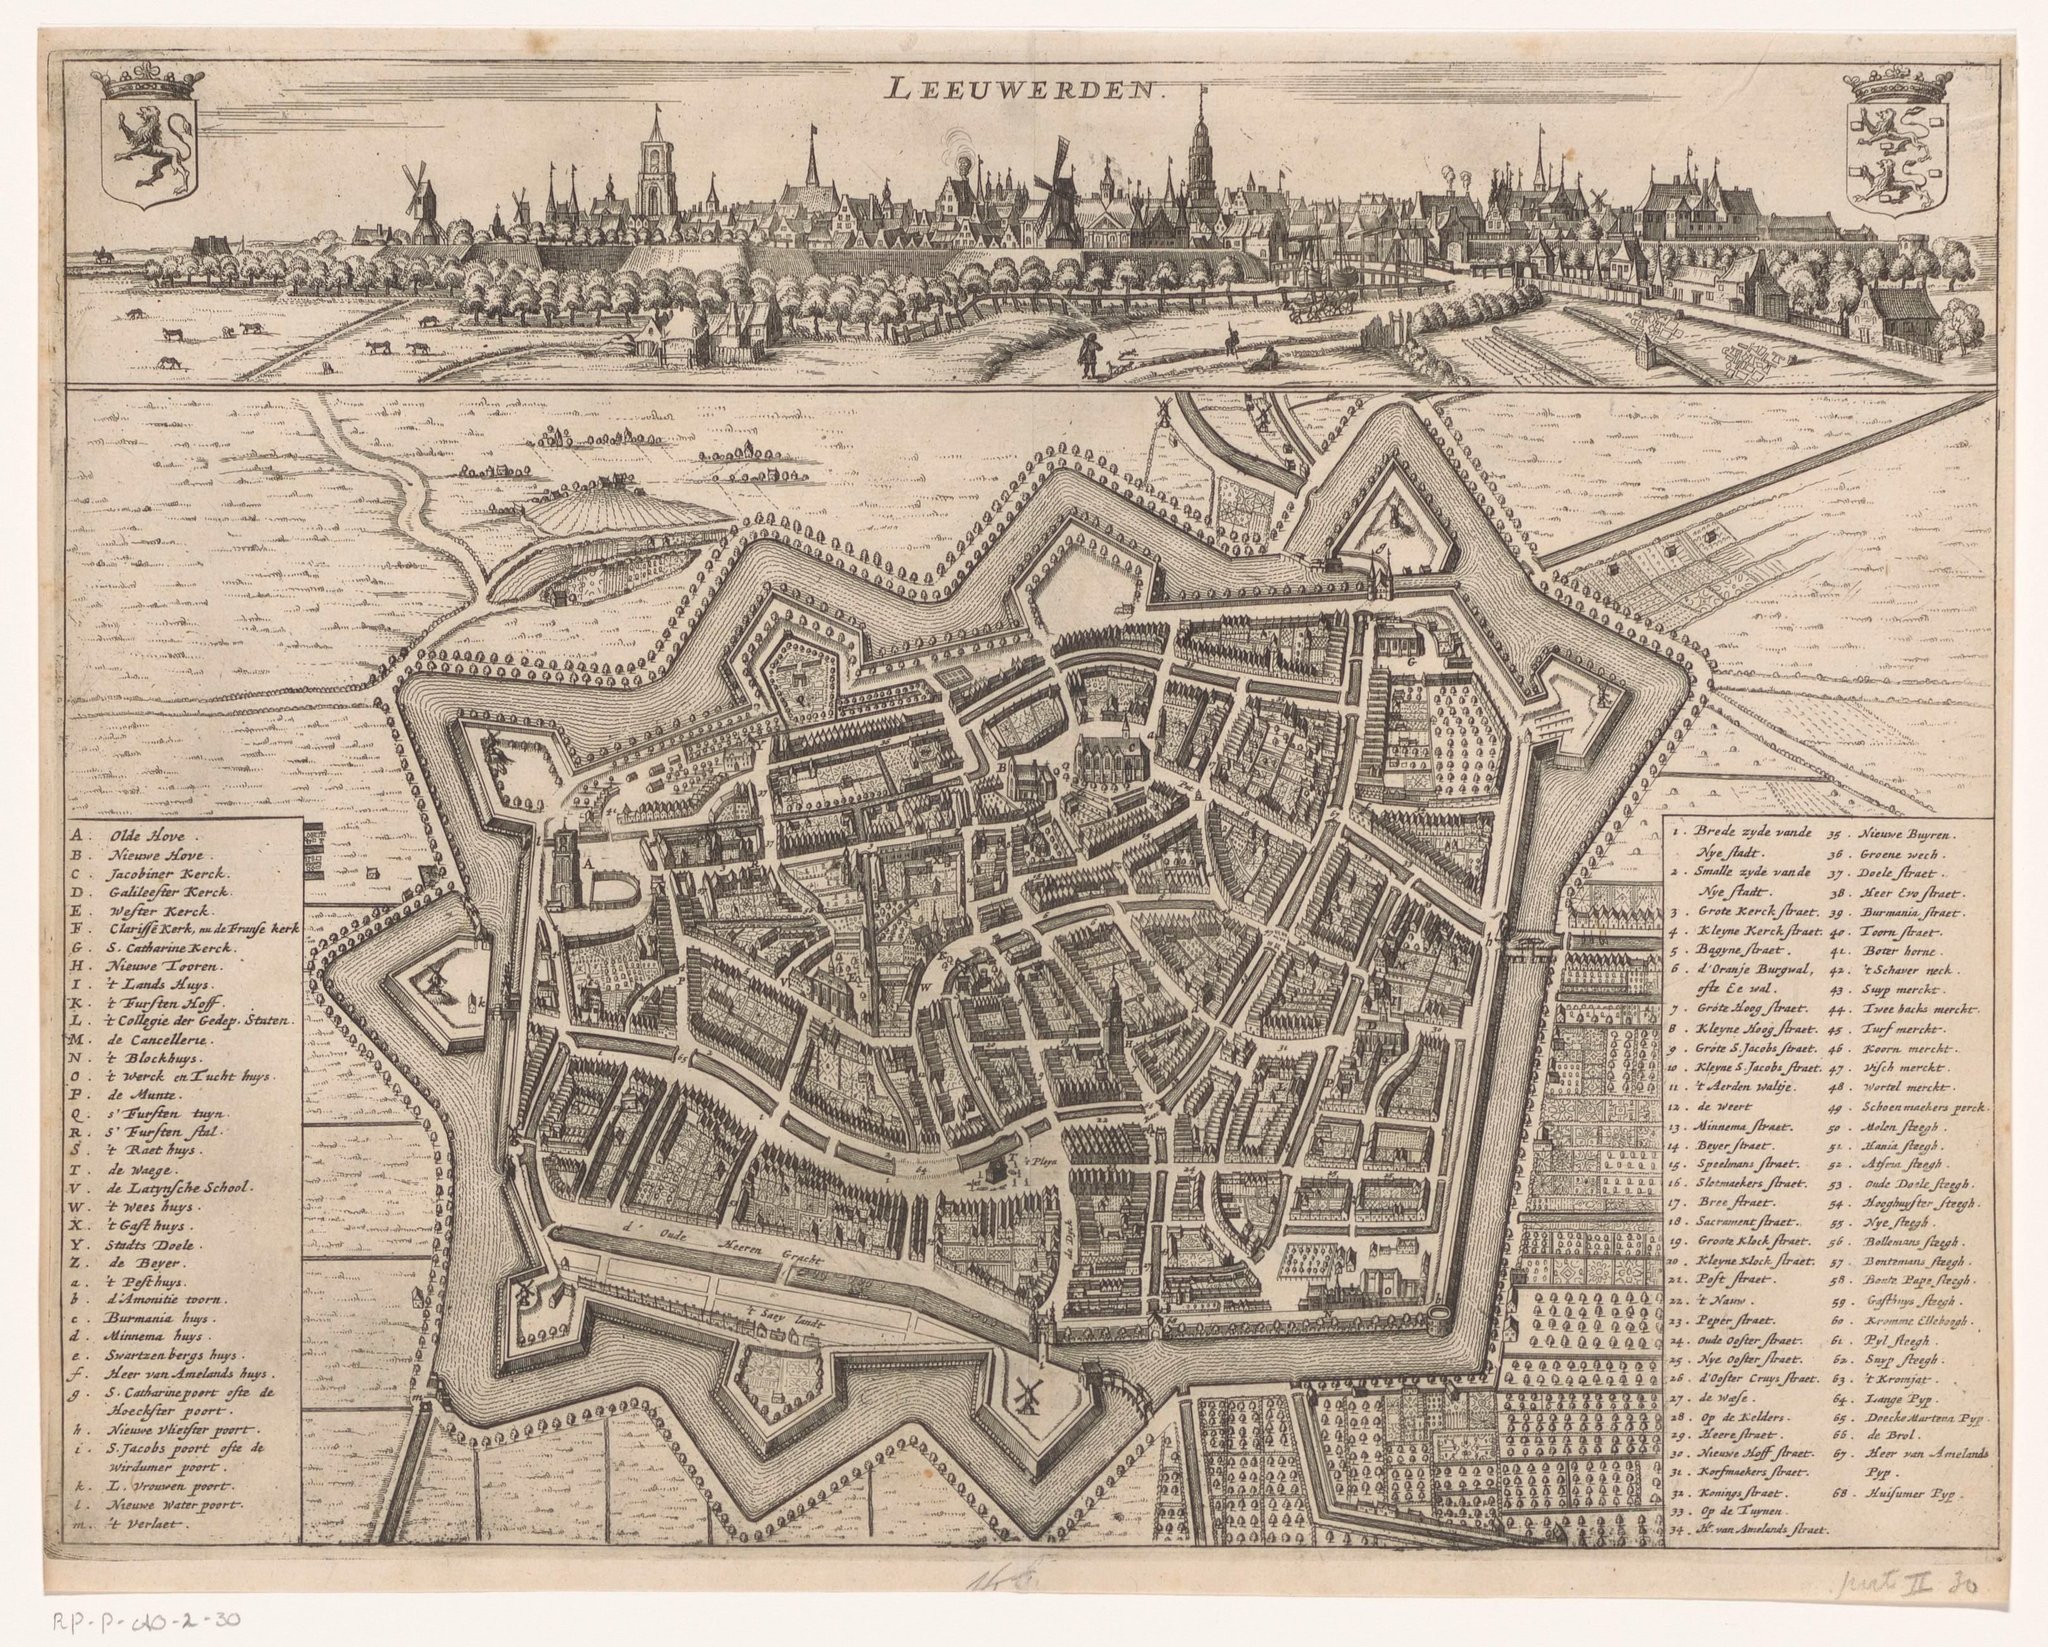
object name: area plan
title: Leeuwerden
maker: jacob van meurs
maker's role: draughtsman, print maker, publisher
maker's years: 1619-1680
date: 1664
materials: paper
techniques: engraving, etching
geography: amsterdam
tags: coat of arms (as symbol of the state, etc.), city-view, and landscape with man-made constructions, maps of cities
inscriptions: collector's mark: Lugt 2228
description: Bovenaan een stadsgezicht van Leeuwarden met daarop links het wapen van Leeuwarden en rechts dat van Friesland. Daaronder een plattegrond van de stad in vogelvluchtperspectief. Links- en rechtsonder een legenda.